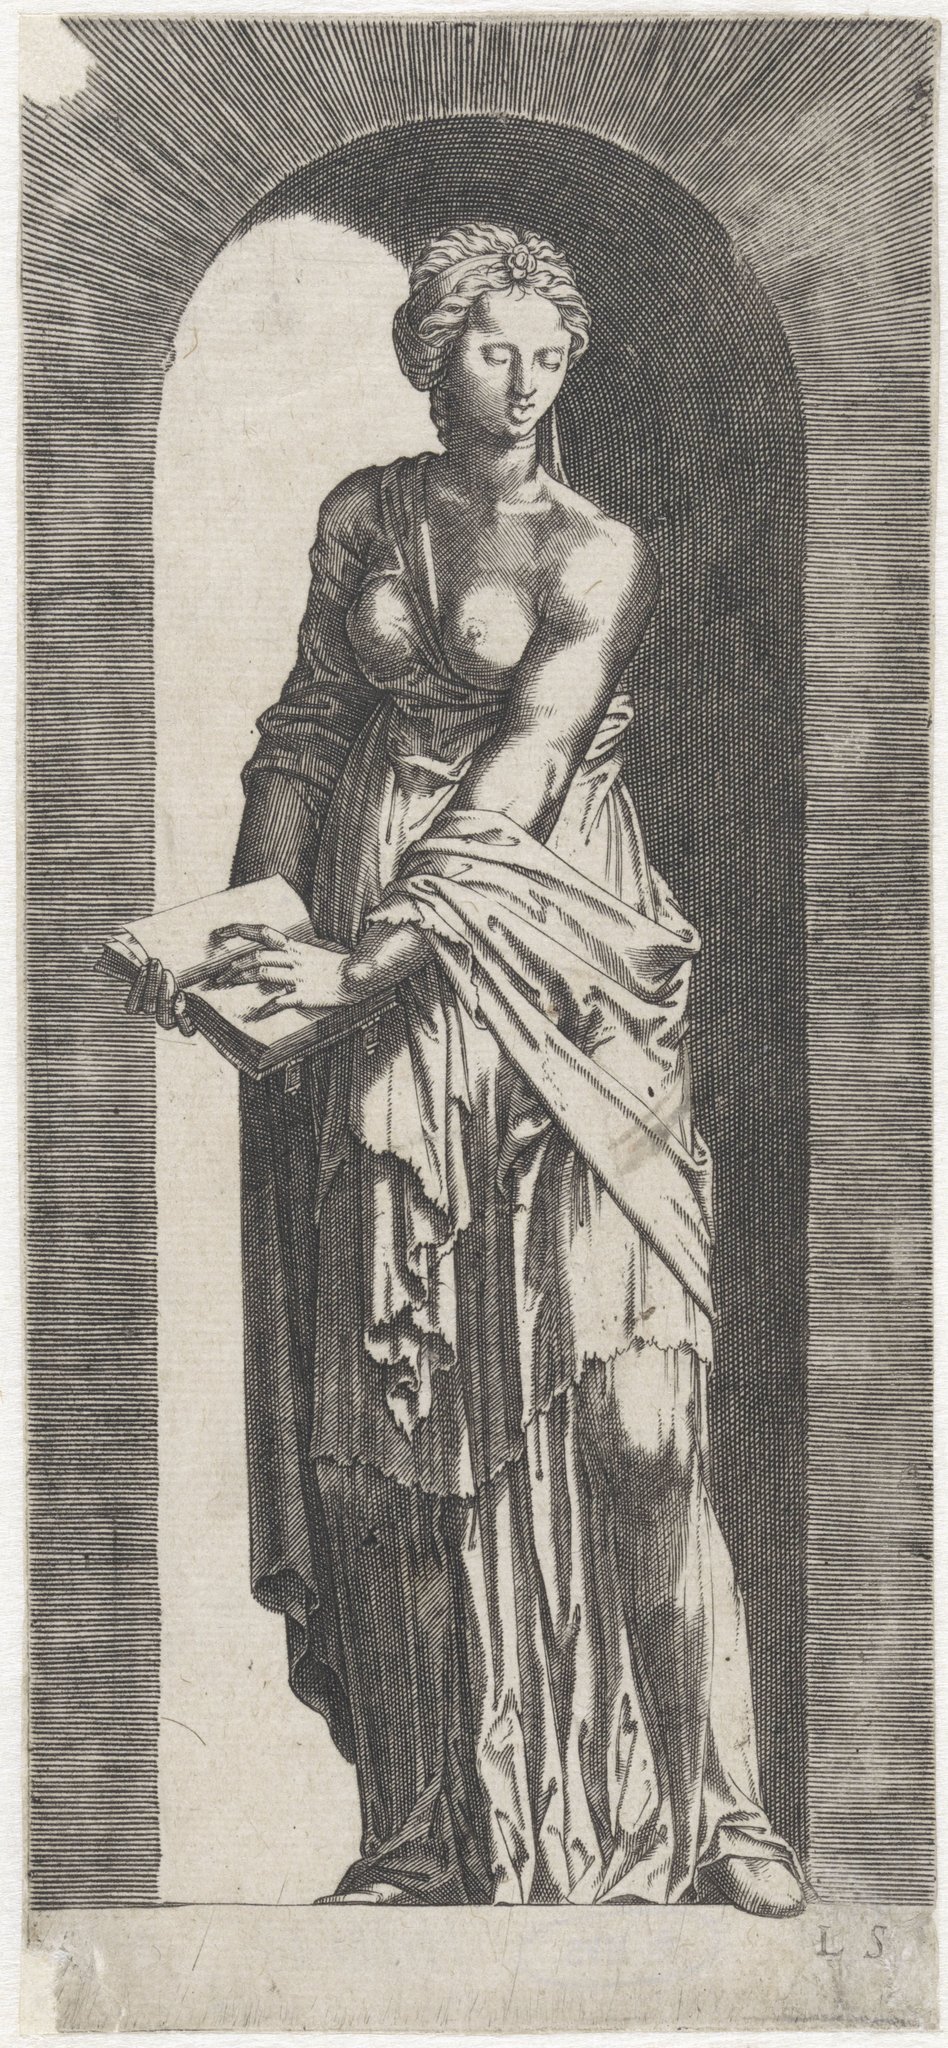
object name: print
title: Sibille met een boek in beide handen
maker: lambertus suavius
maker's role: print maker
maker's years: 1514-1564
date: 1520-1567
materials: paper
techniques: engraving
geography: southern netherlands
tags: sibyls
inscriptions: collector's mark: Lugt 2228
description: Een Sibille staande in een nis met een ontblote borst. In haar handen houdt zij een boek.